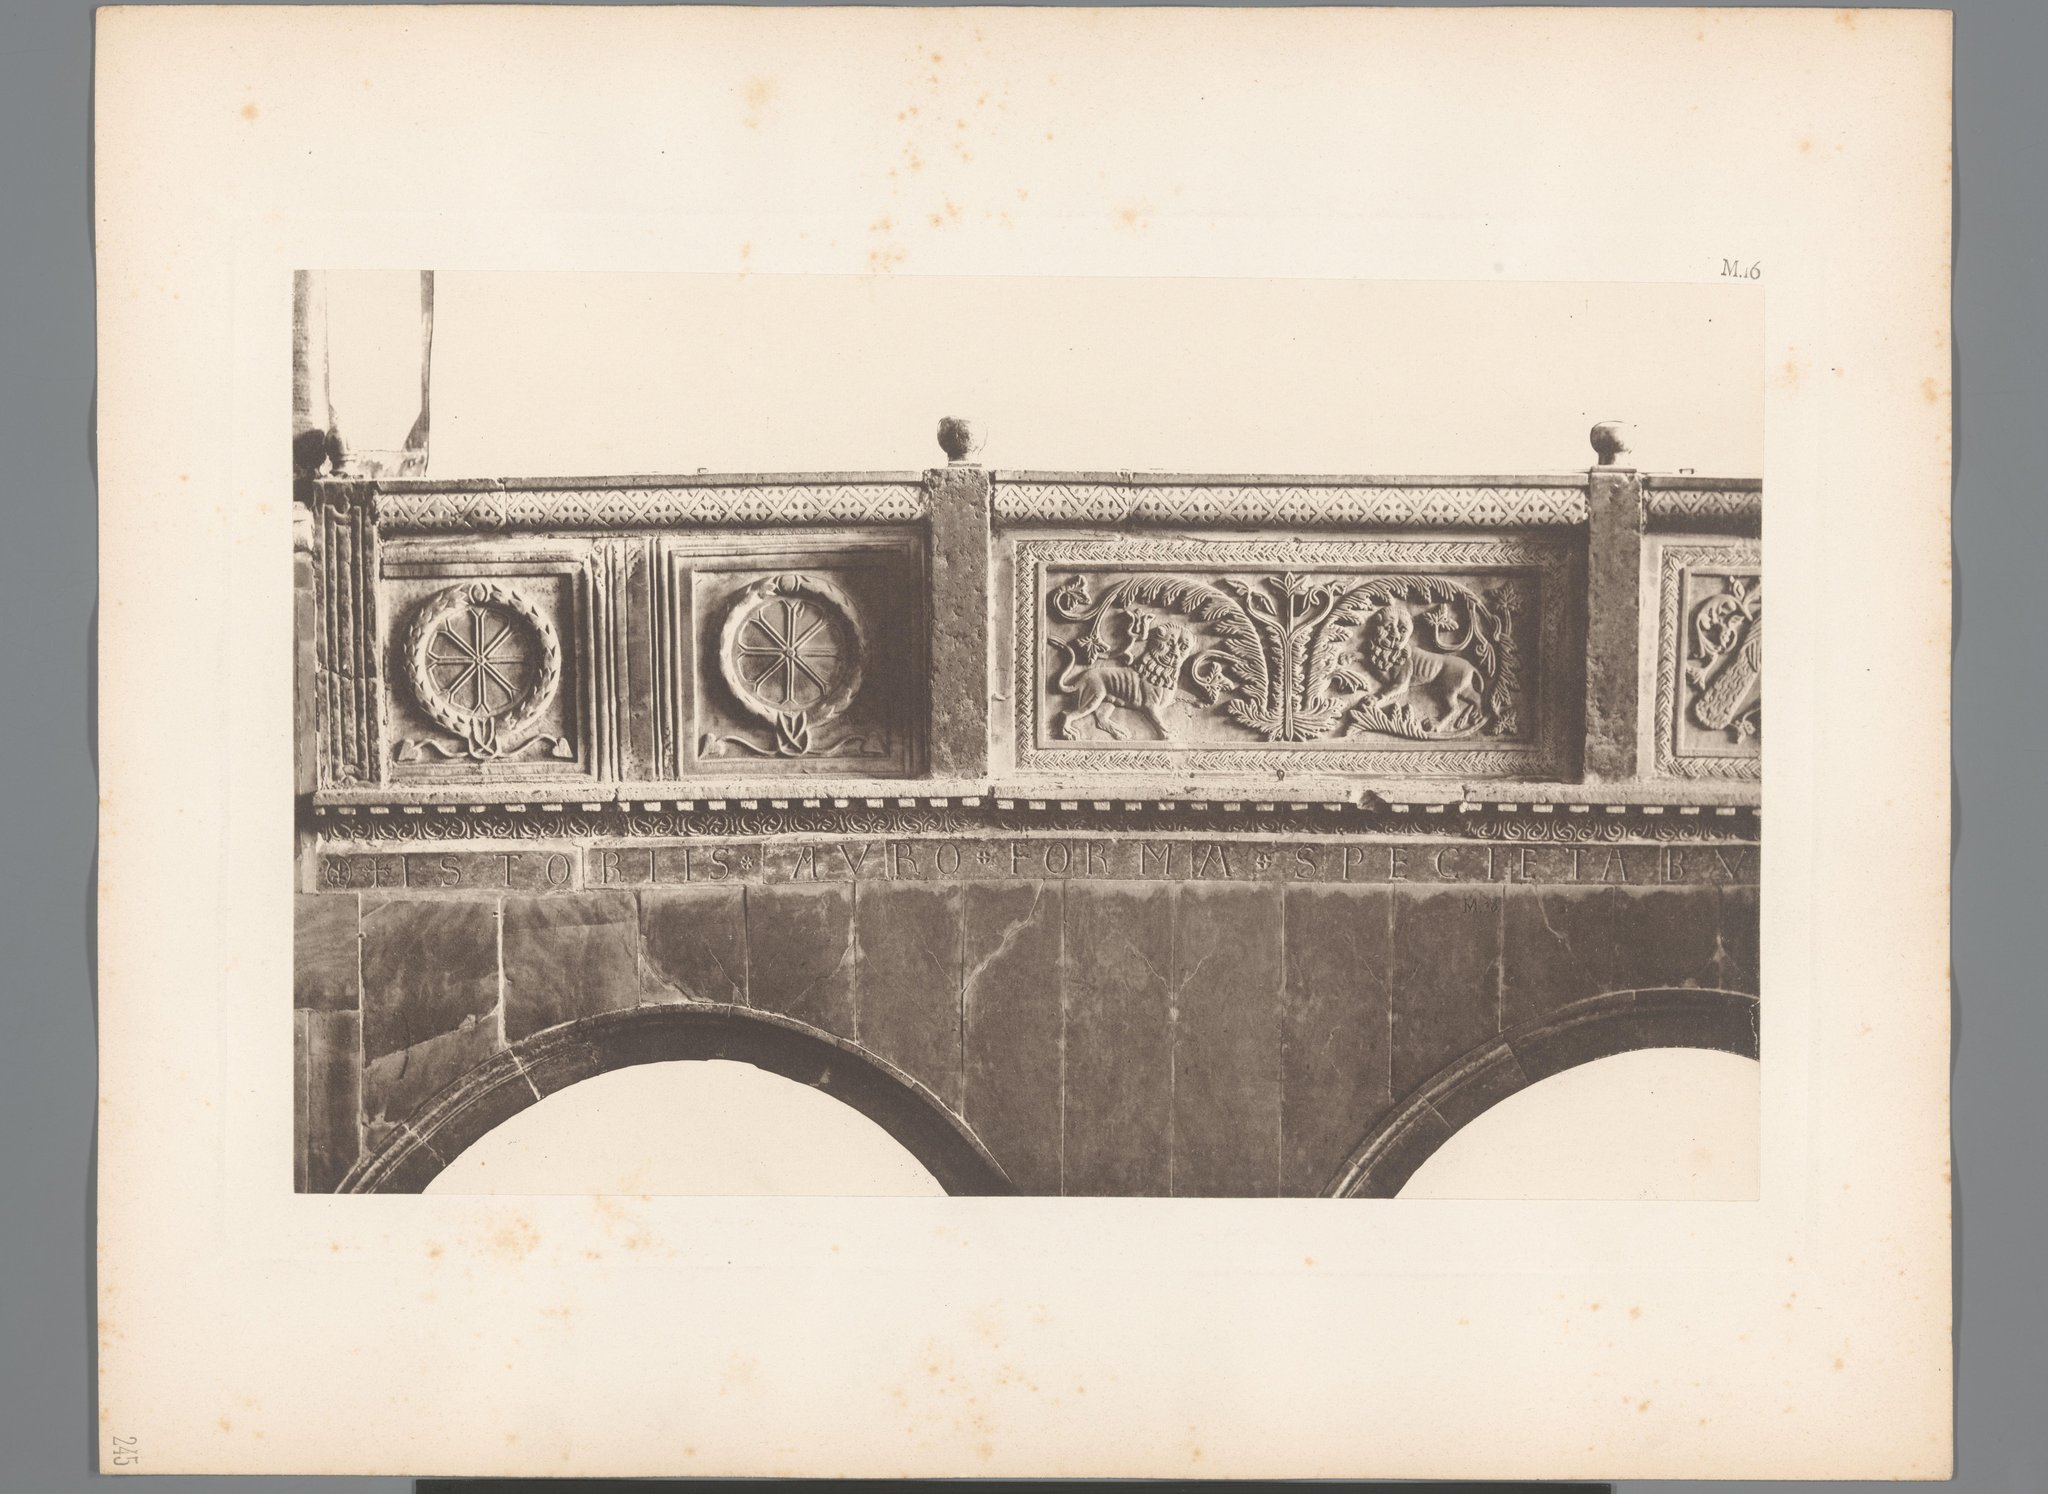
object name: photomechanical print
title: Reliëf met leeuwen van de San Marco in Venetië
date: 1880-1885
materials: paper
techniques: photograph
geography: venice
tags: piece of sculpture, reproduction of a piece of sculpture, beasts of prey, predatory animals: lion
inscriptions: number: ‘M.16’, number: ‘245’, number: ‘M.16.’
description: Deze prent maakt deel uit van een omslag met 58 prenten op 50 bladen.